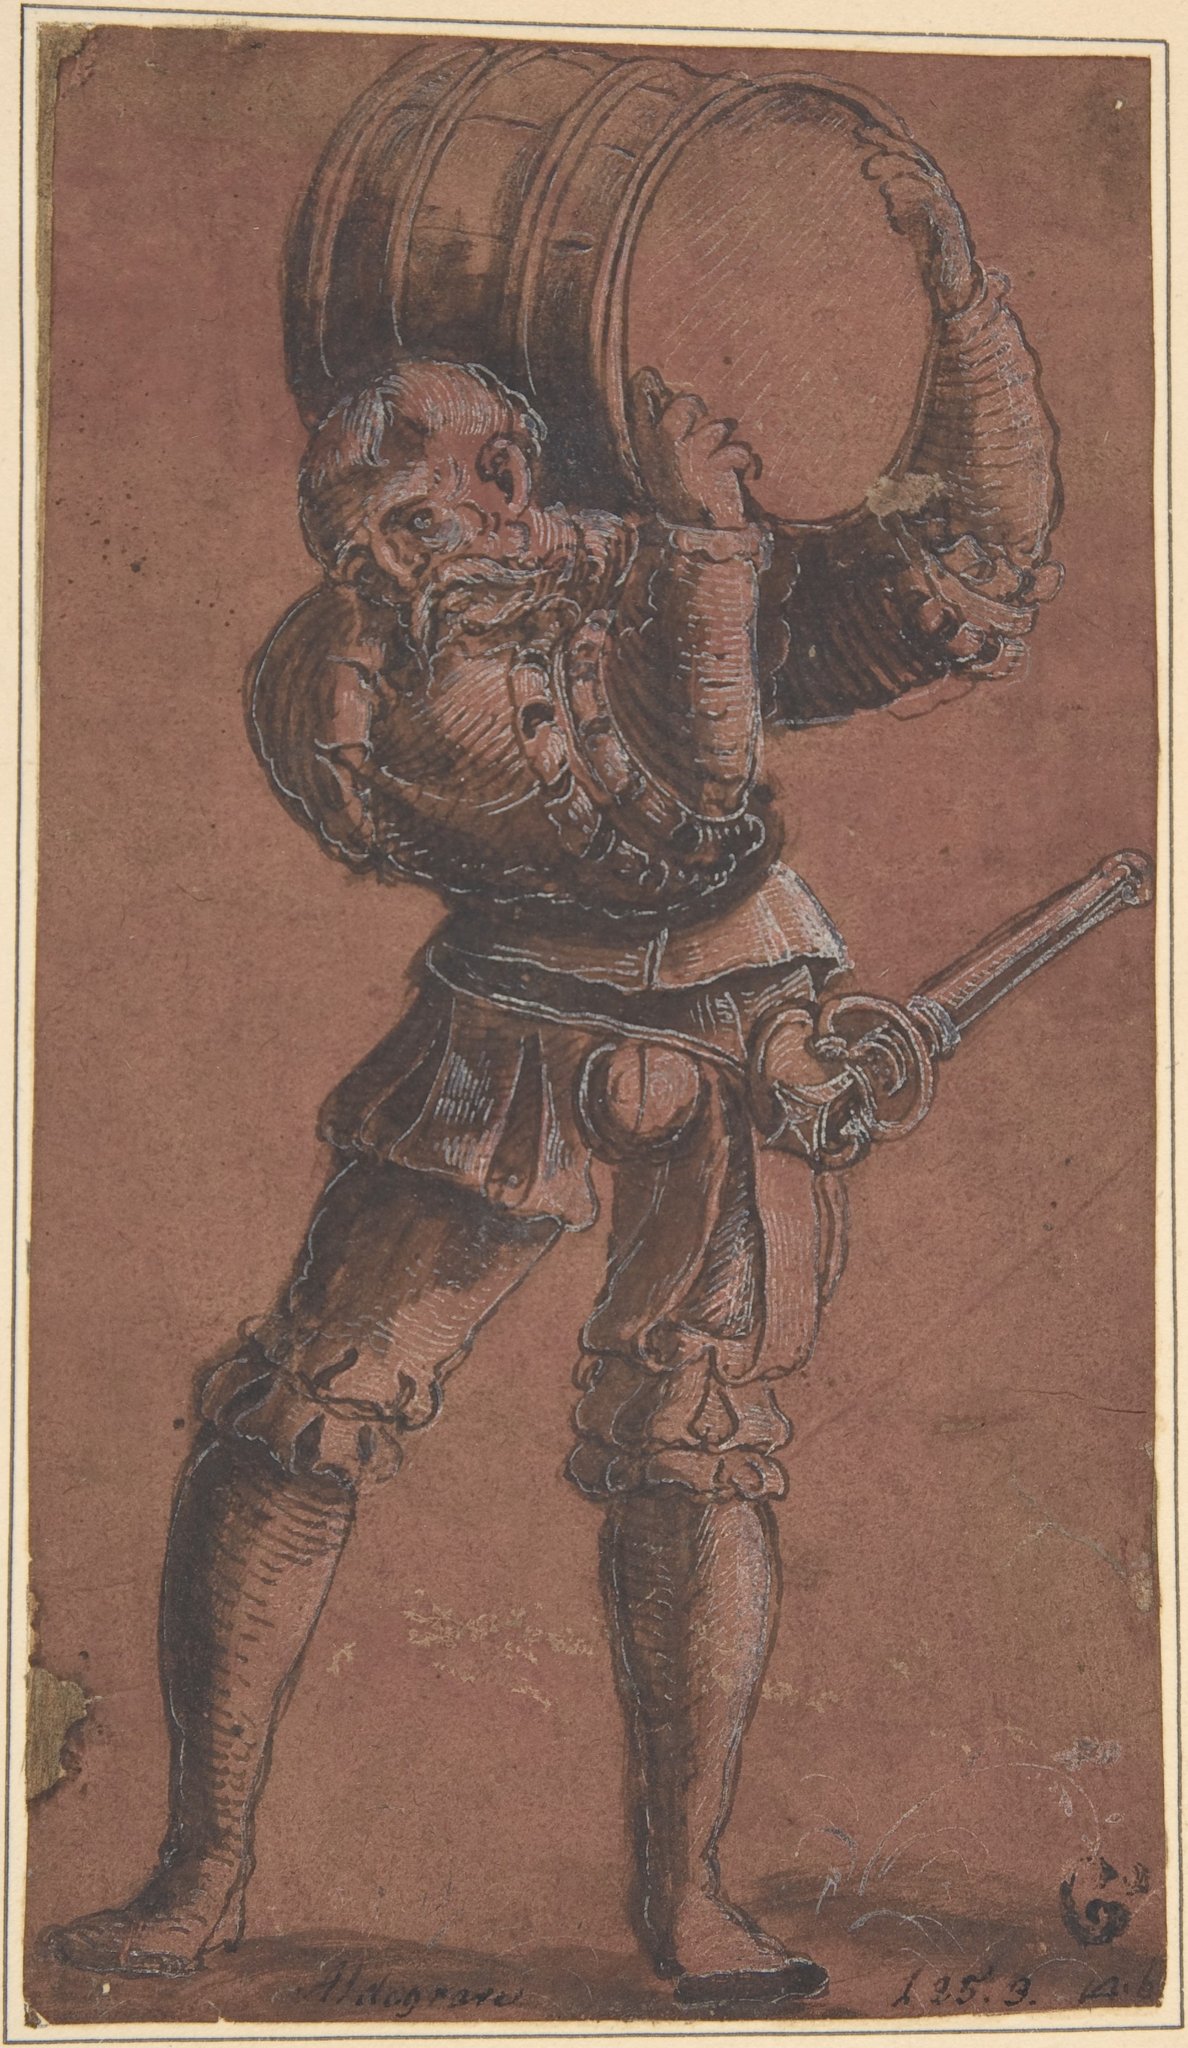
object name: drawing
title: Landsknecht Carrying a Barrel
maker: georg lemberger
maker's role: artist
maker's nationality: german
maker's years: 1490-1540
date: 1467-1566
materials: ink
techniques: brush, heightening, wash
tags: men,barrels